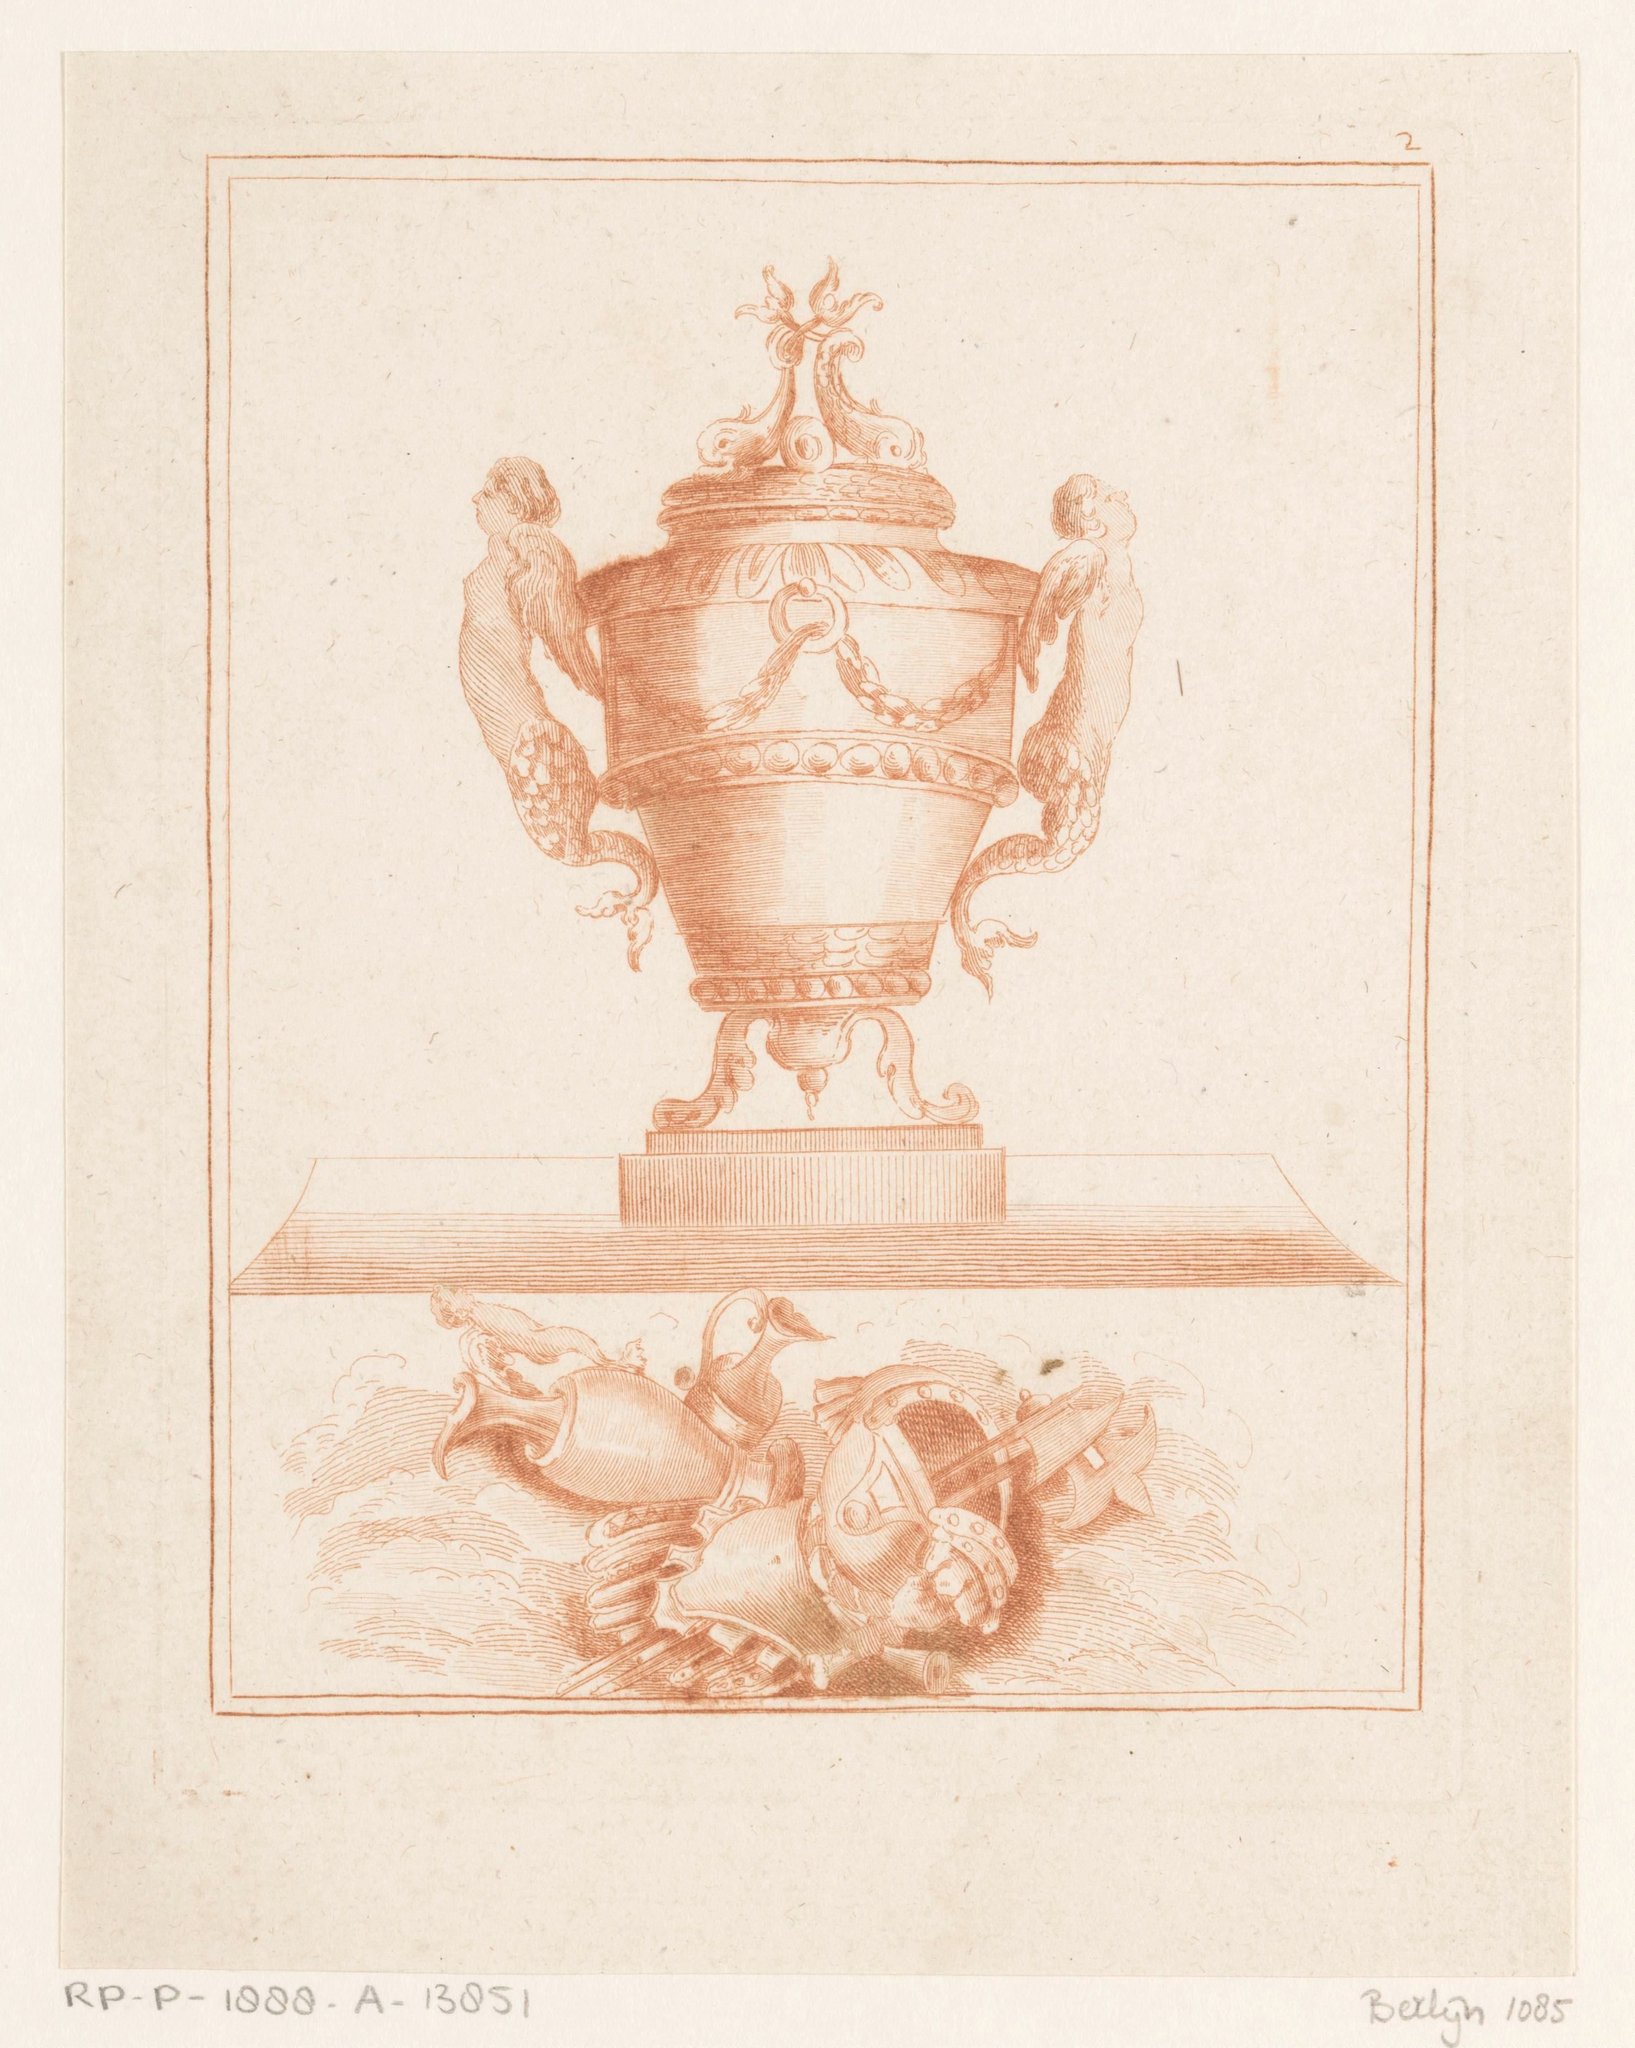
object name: ornament print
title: Vaas met meerminnen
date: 1768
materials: paper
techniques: etching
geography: paris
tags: merman - aa - mermaid, siren, vase ~ ornament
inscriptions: collector's mark: Lugt 2228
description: Een vaas met meerminnen en dolfijnen. Daaronder een harnas en twee kannen.